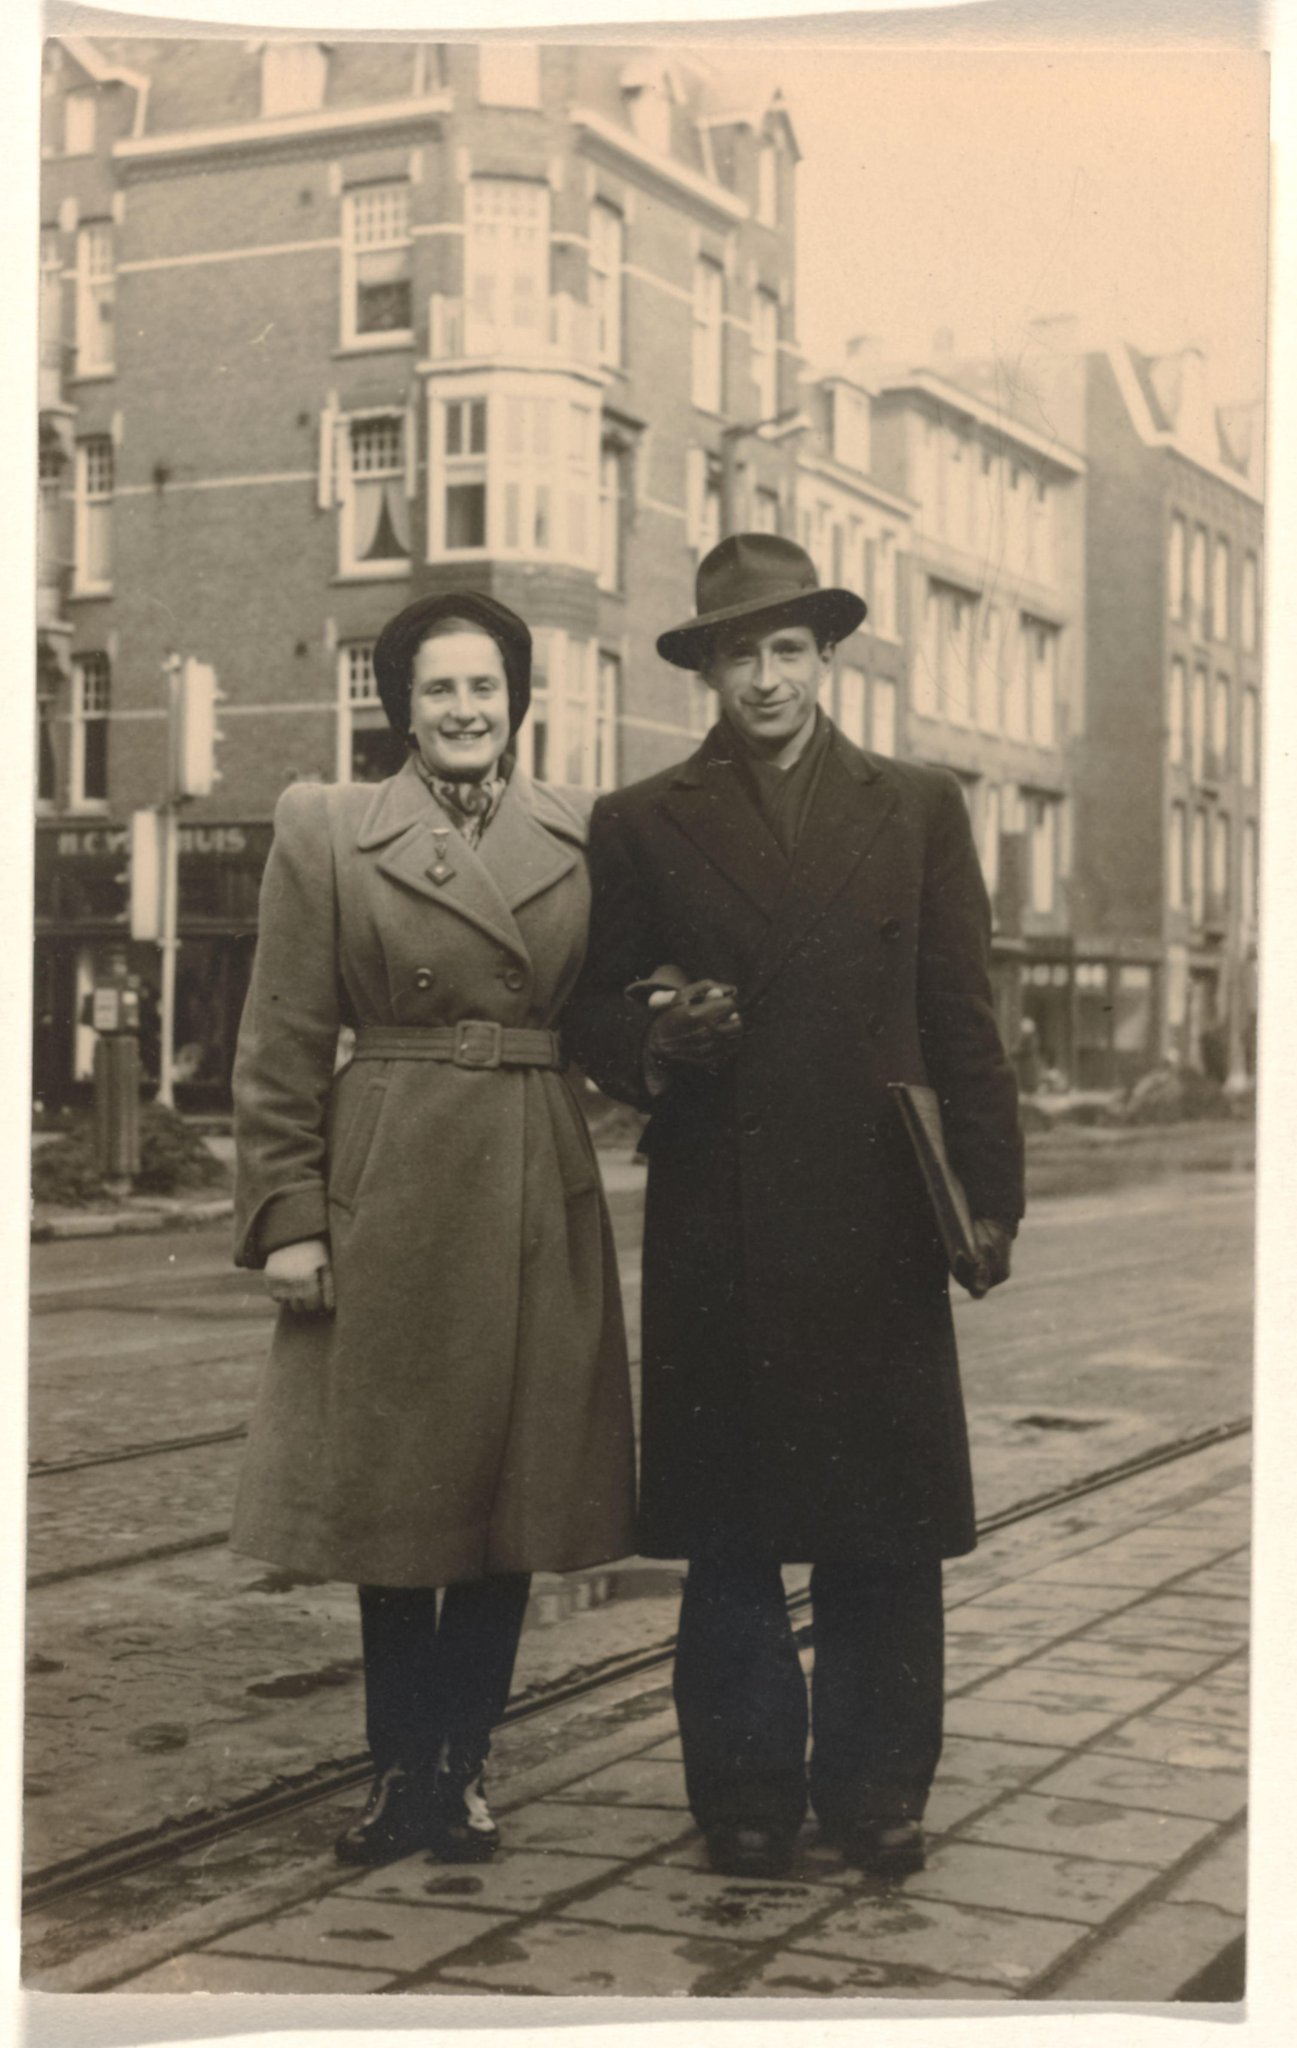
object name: photograph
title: Isabel Wachenheimer in lange jas met Leo Blumensohn met gleufhoed op straat in Amsterdam, mei 1947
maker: Anonymous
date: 1905-1947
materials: photographic support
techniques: gelatin silver print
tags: leiden, isabel wachenheimer-elon, amsterdam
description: Isabel Wachenheimer in lange jas met Leo Blumensohn met gleufhoed op straat in Amsterdam.